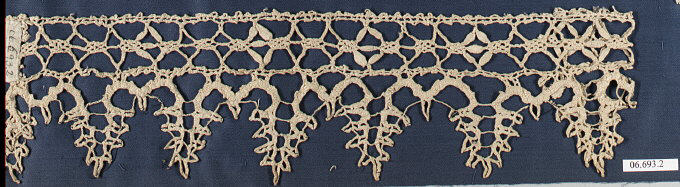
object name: edging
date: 1501-1600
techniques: lace